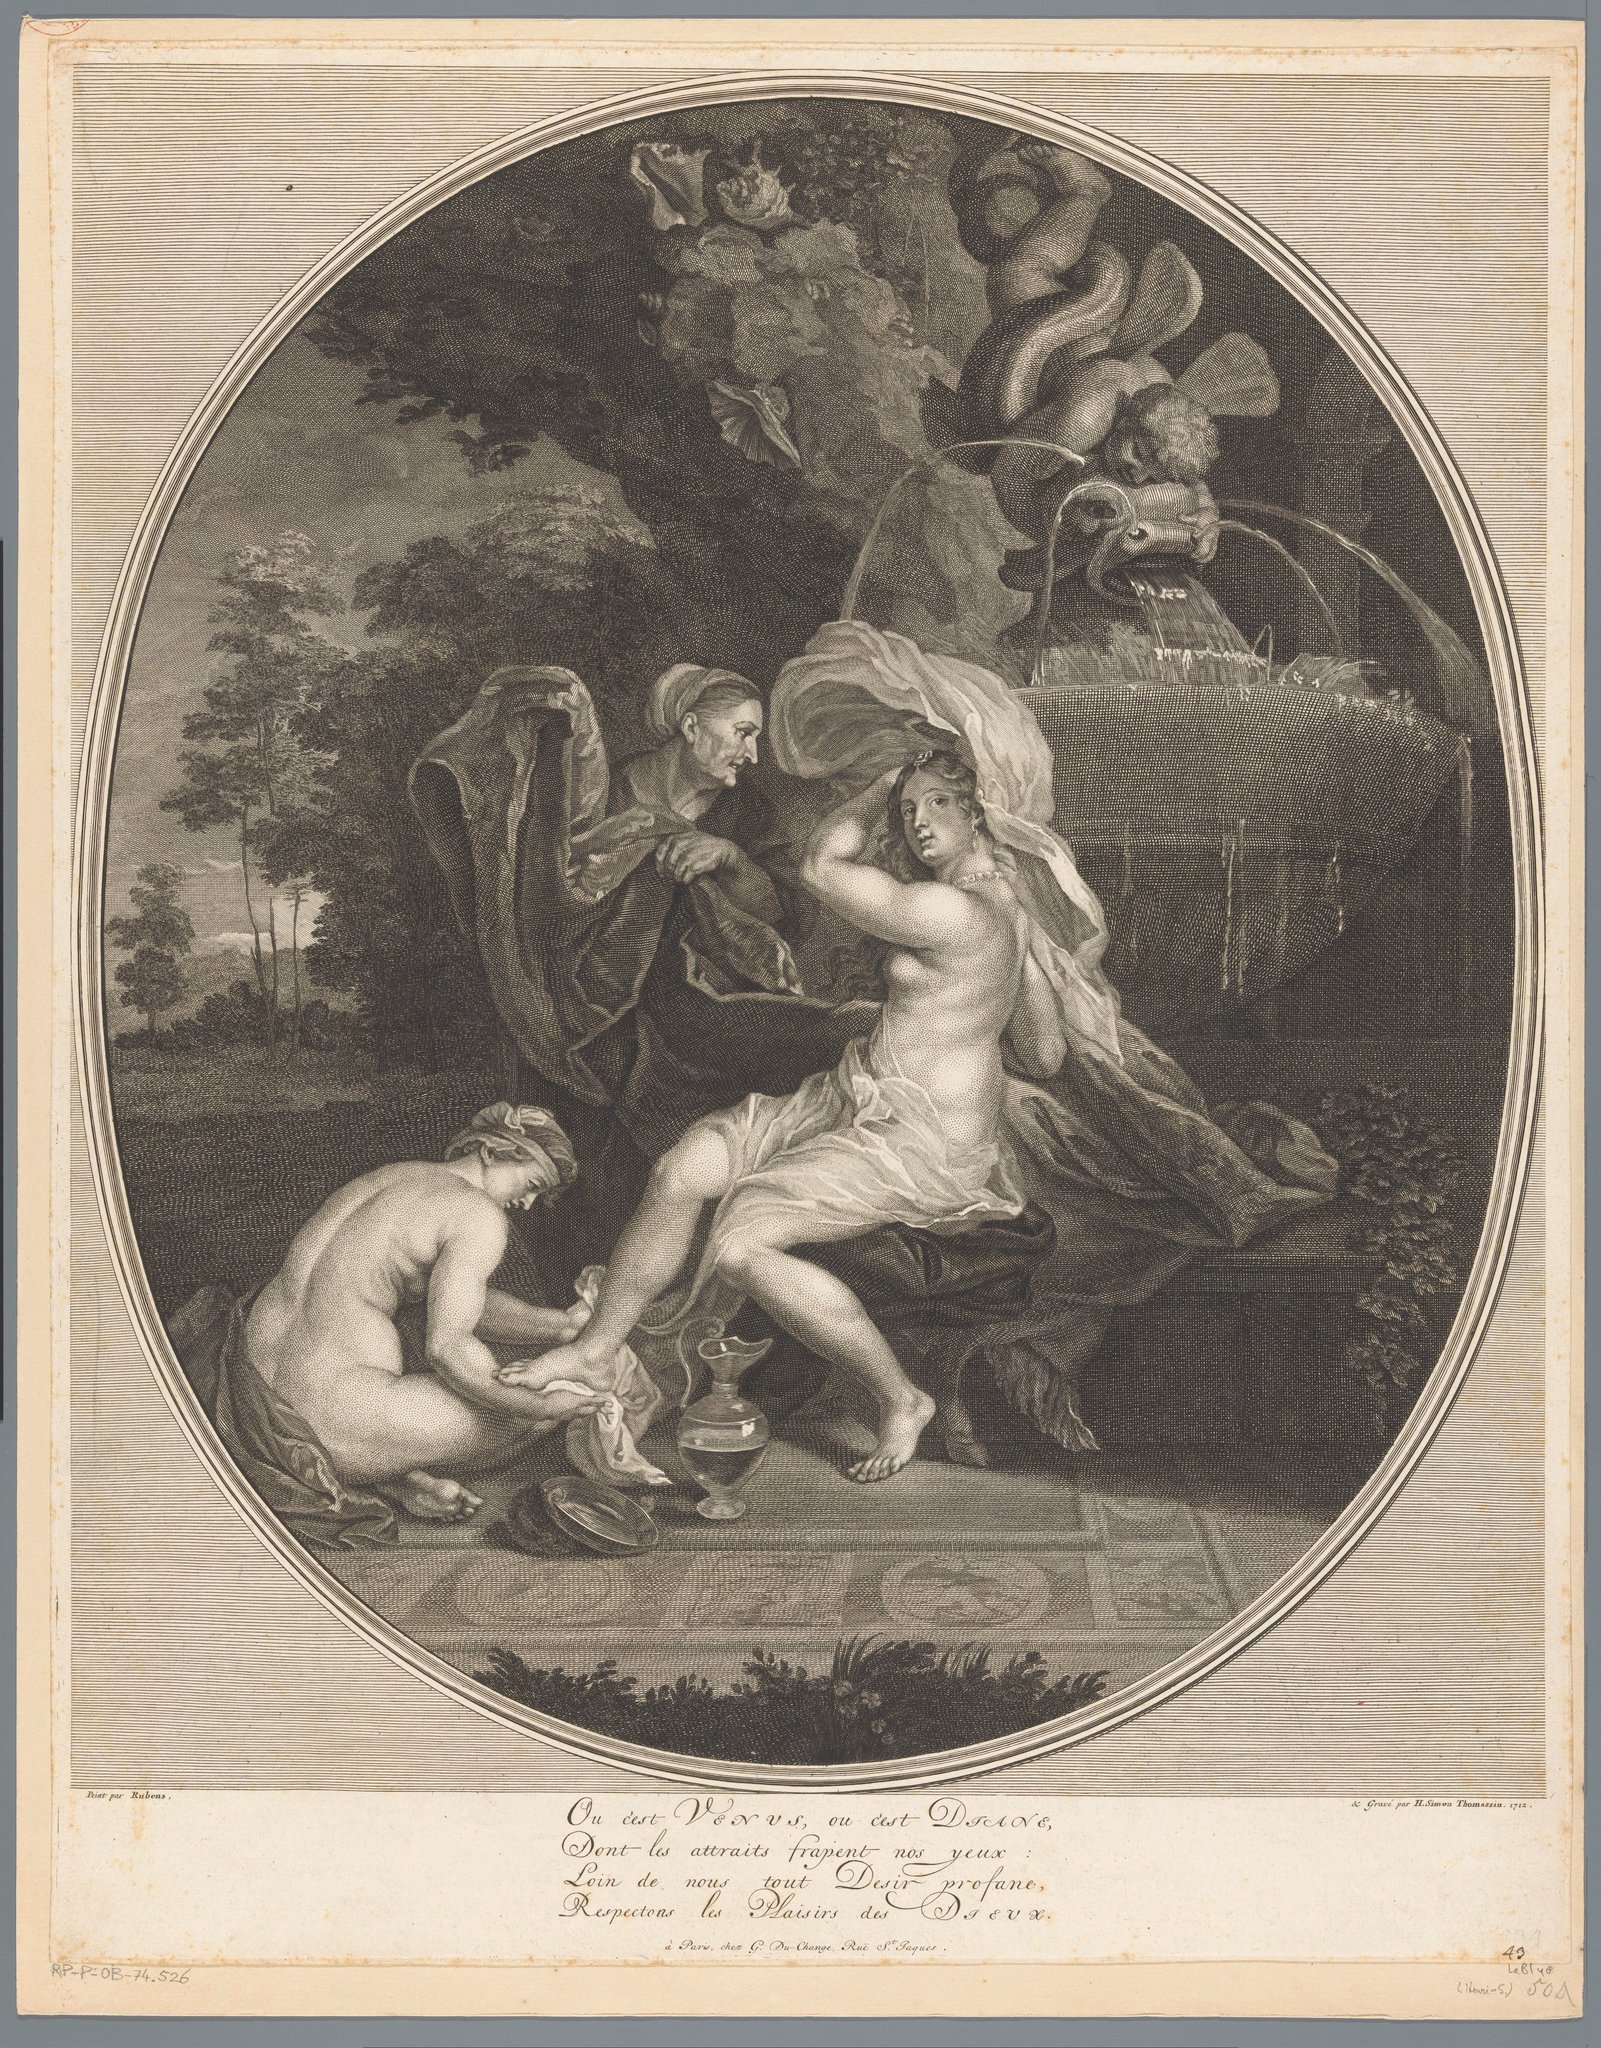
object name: print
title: Badende jonge vrouw, mogelijk Venus of Diana, bij een fontein met twee bedienden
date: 1712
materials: paper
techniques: engraving, etching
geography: paris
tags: bath of venus, garden fountain, diana bathing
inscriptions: collector's mark: Lugt 240, number: ‘43’